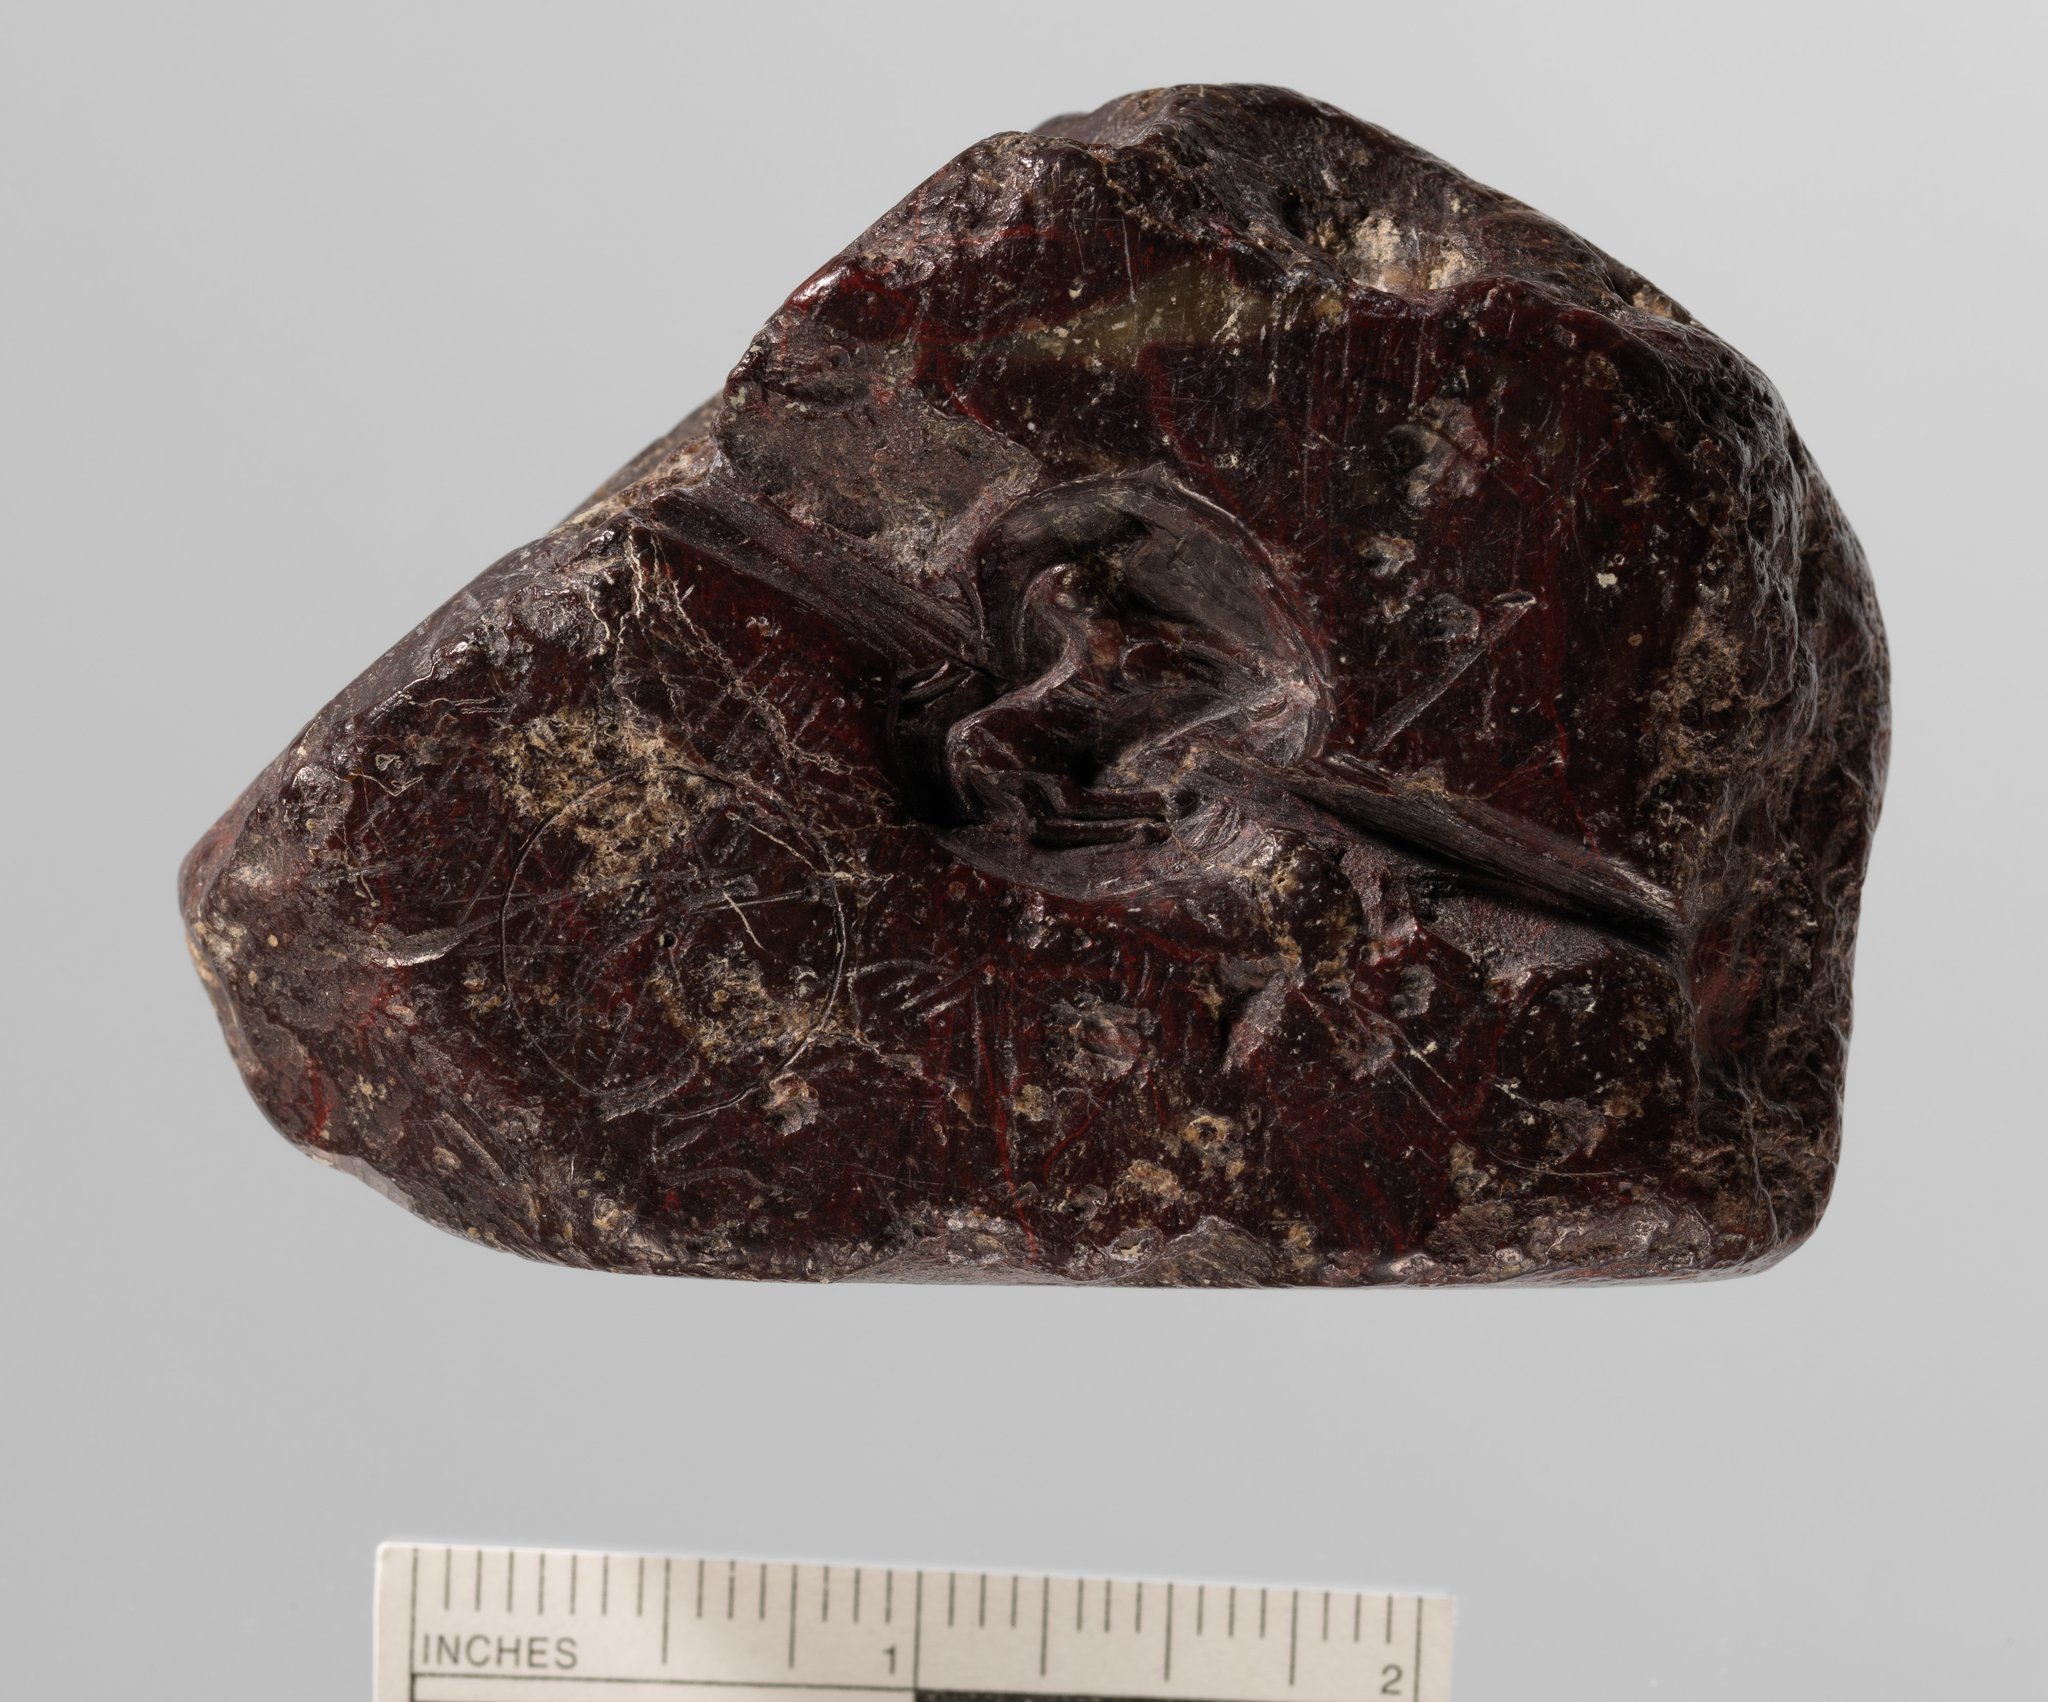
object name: seal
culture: minoan, crete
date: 2000-1450 BCE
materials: stone